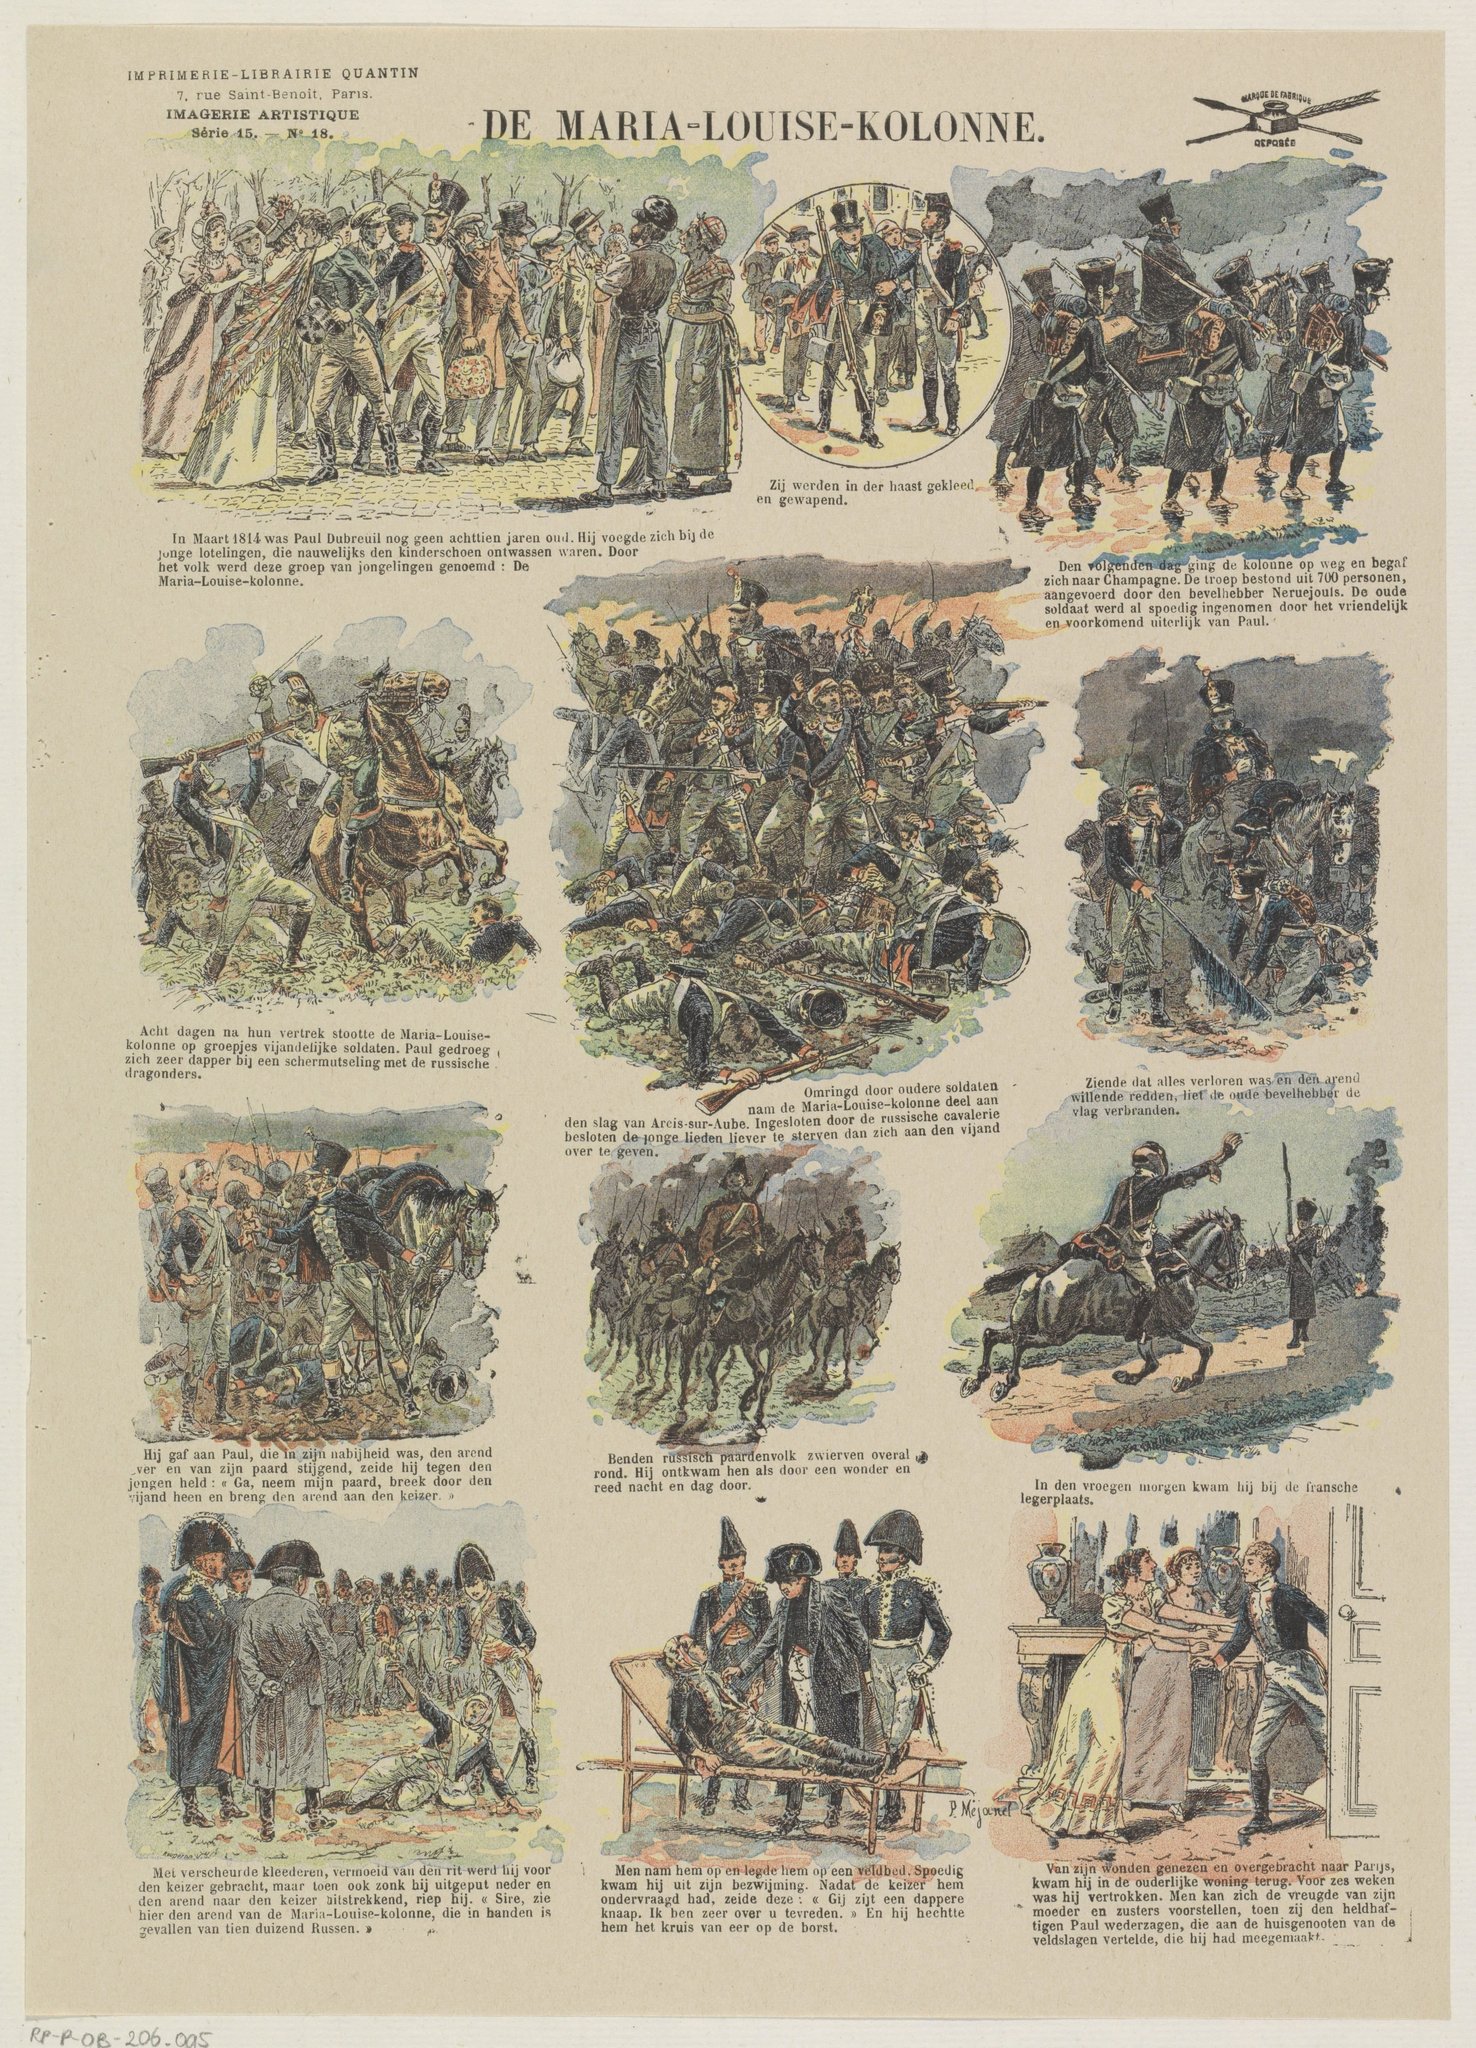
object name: popular print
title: Imagerie Artistique / Série 15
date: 1876-1890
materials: paper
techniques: lithograph, letterpress printing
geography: paris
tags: napoleon i (emperor of the french), tales and fairy tales, the soldier; the soldier's life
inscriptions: collector's mark: Lugt 2760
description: Blad met 12 voorstellingen over een dappere soldaat in het leger van Napoleon. Onder elke afbeelding een onderschrift. Genummerd linksboven: Série 15. - No. 18.